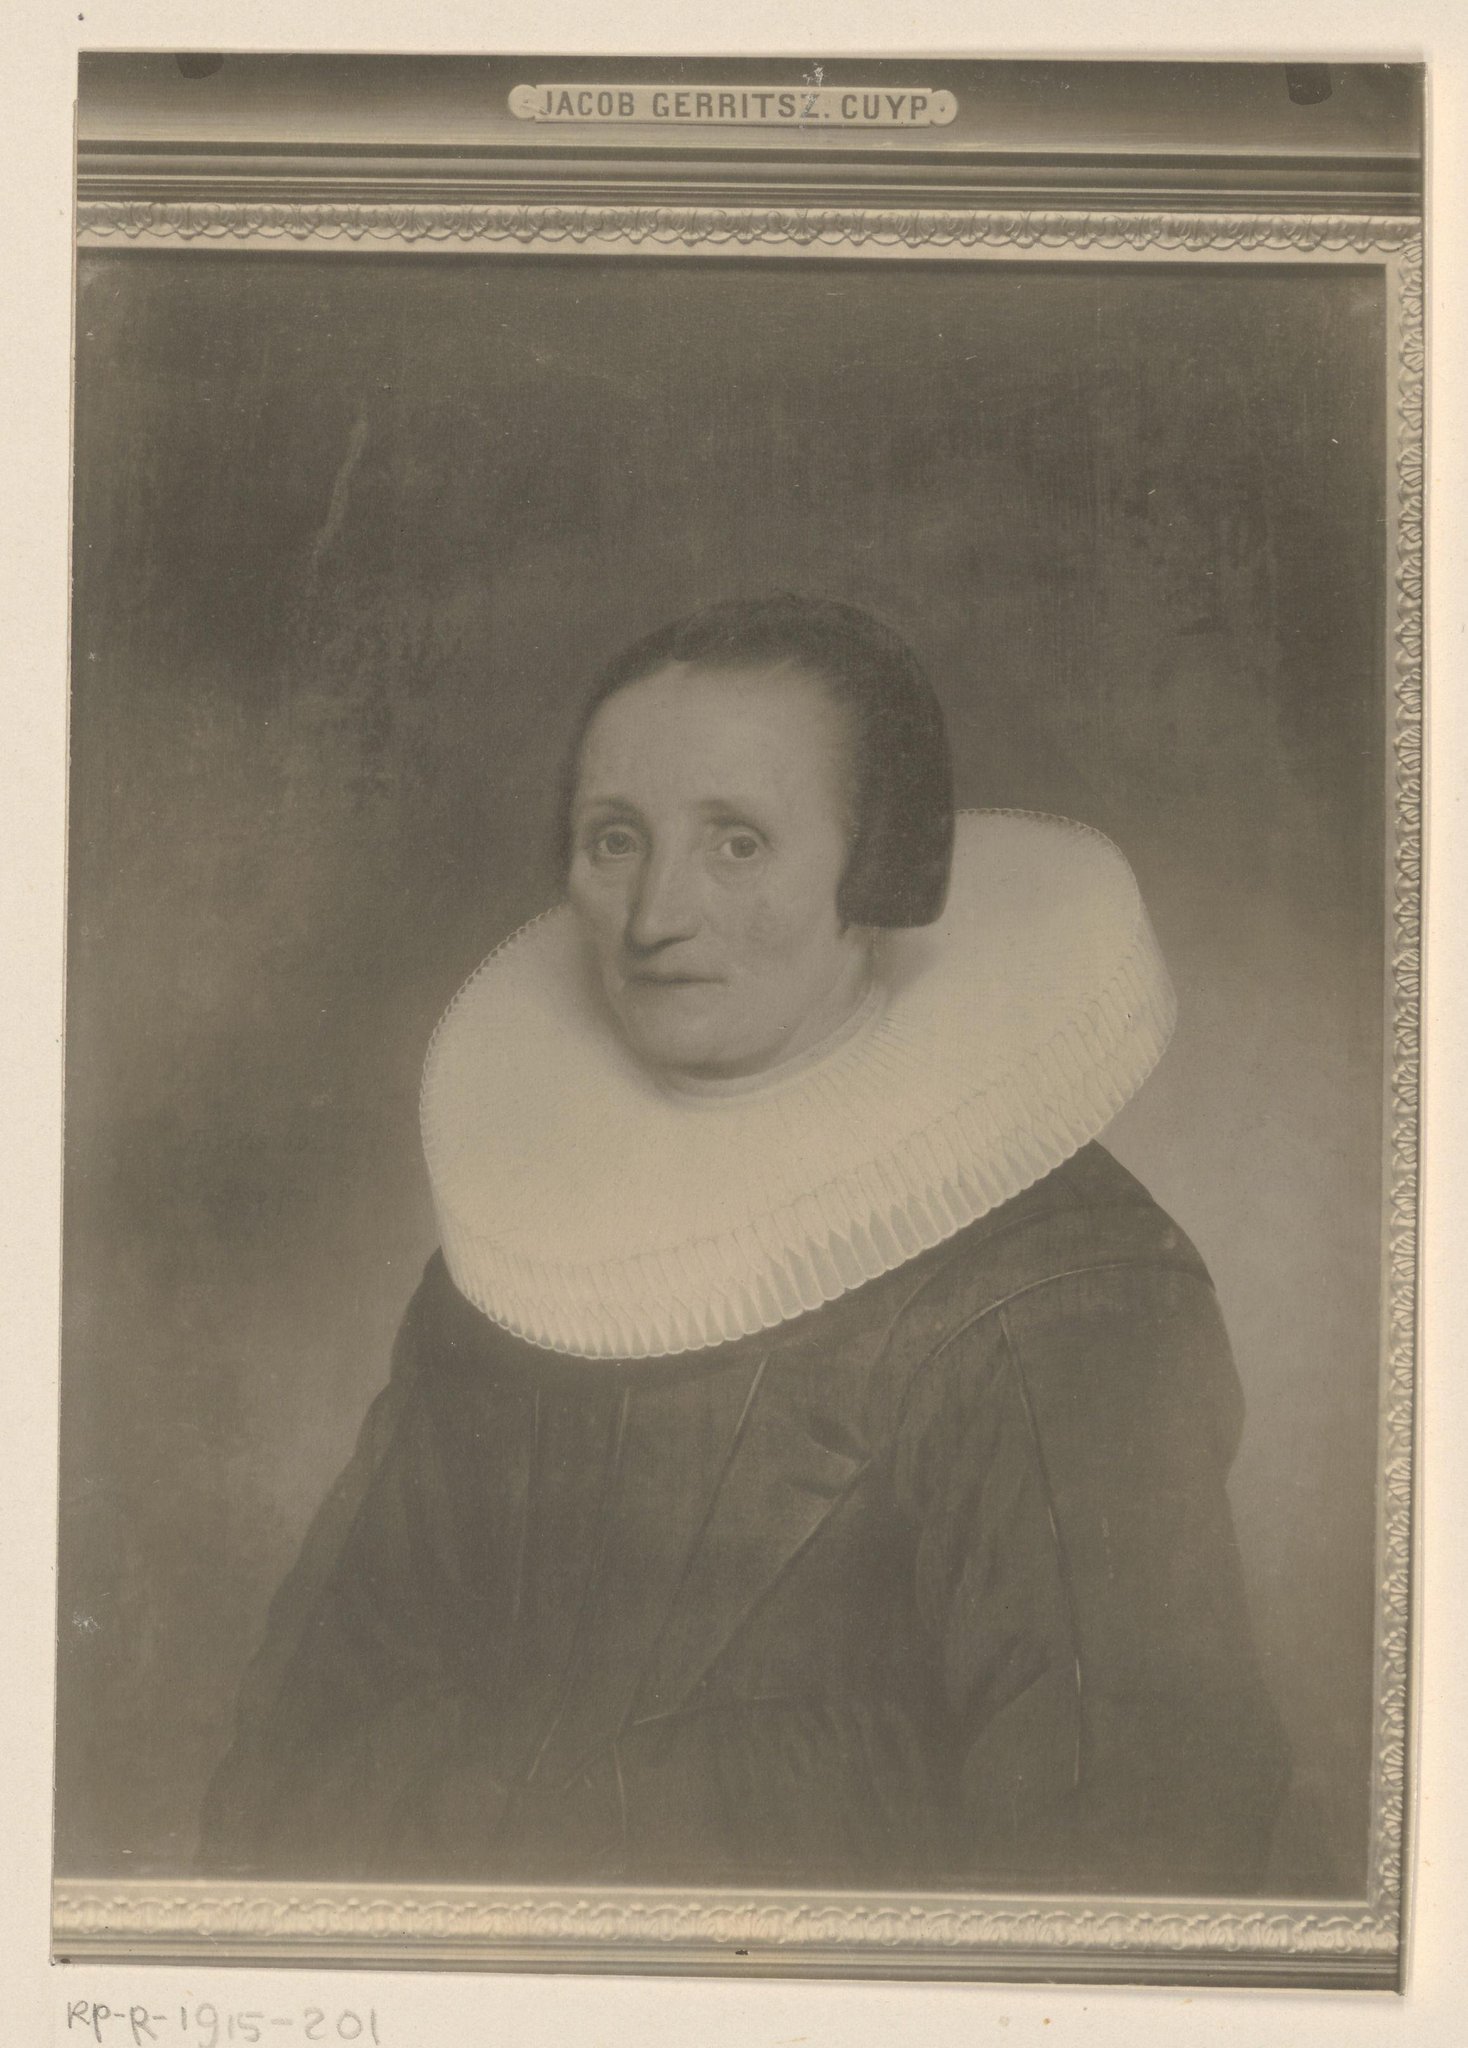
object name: photograph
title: Portret van Johanna Margaretha de Geer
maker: Anonymous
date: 1890-1915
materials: paper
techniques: photography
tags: historical persons